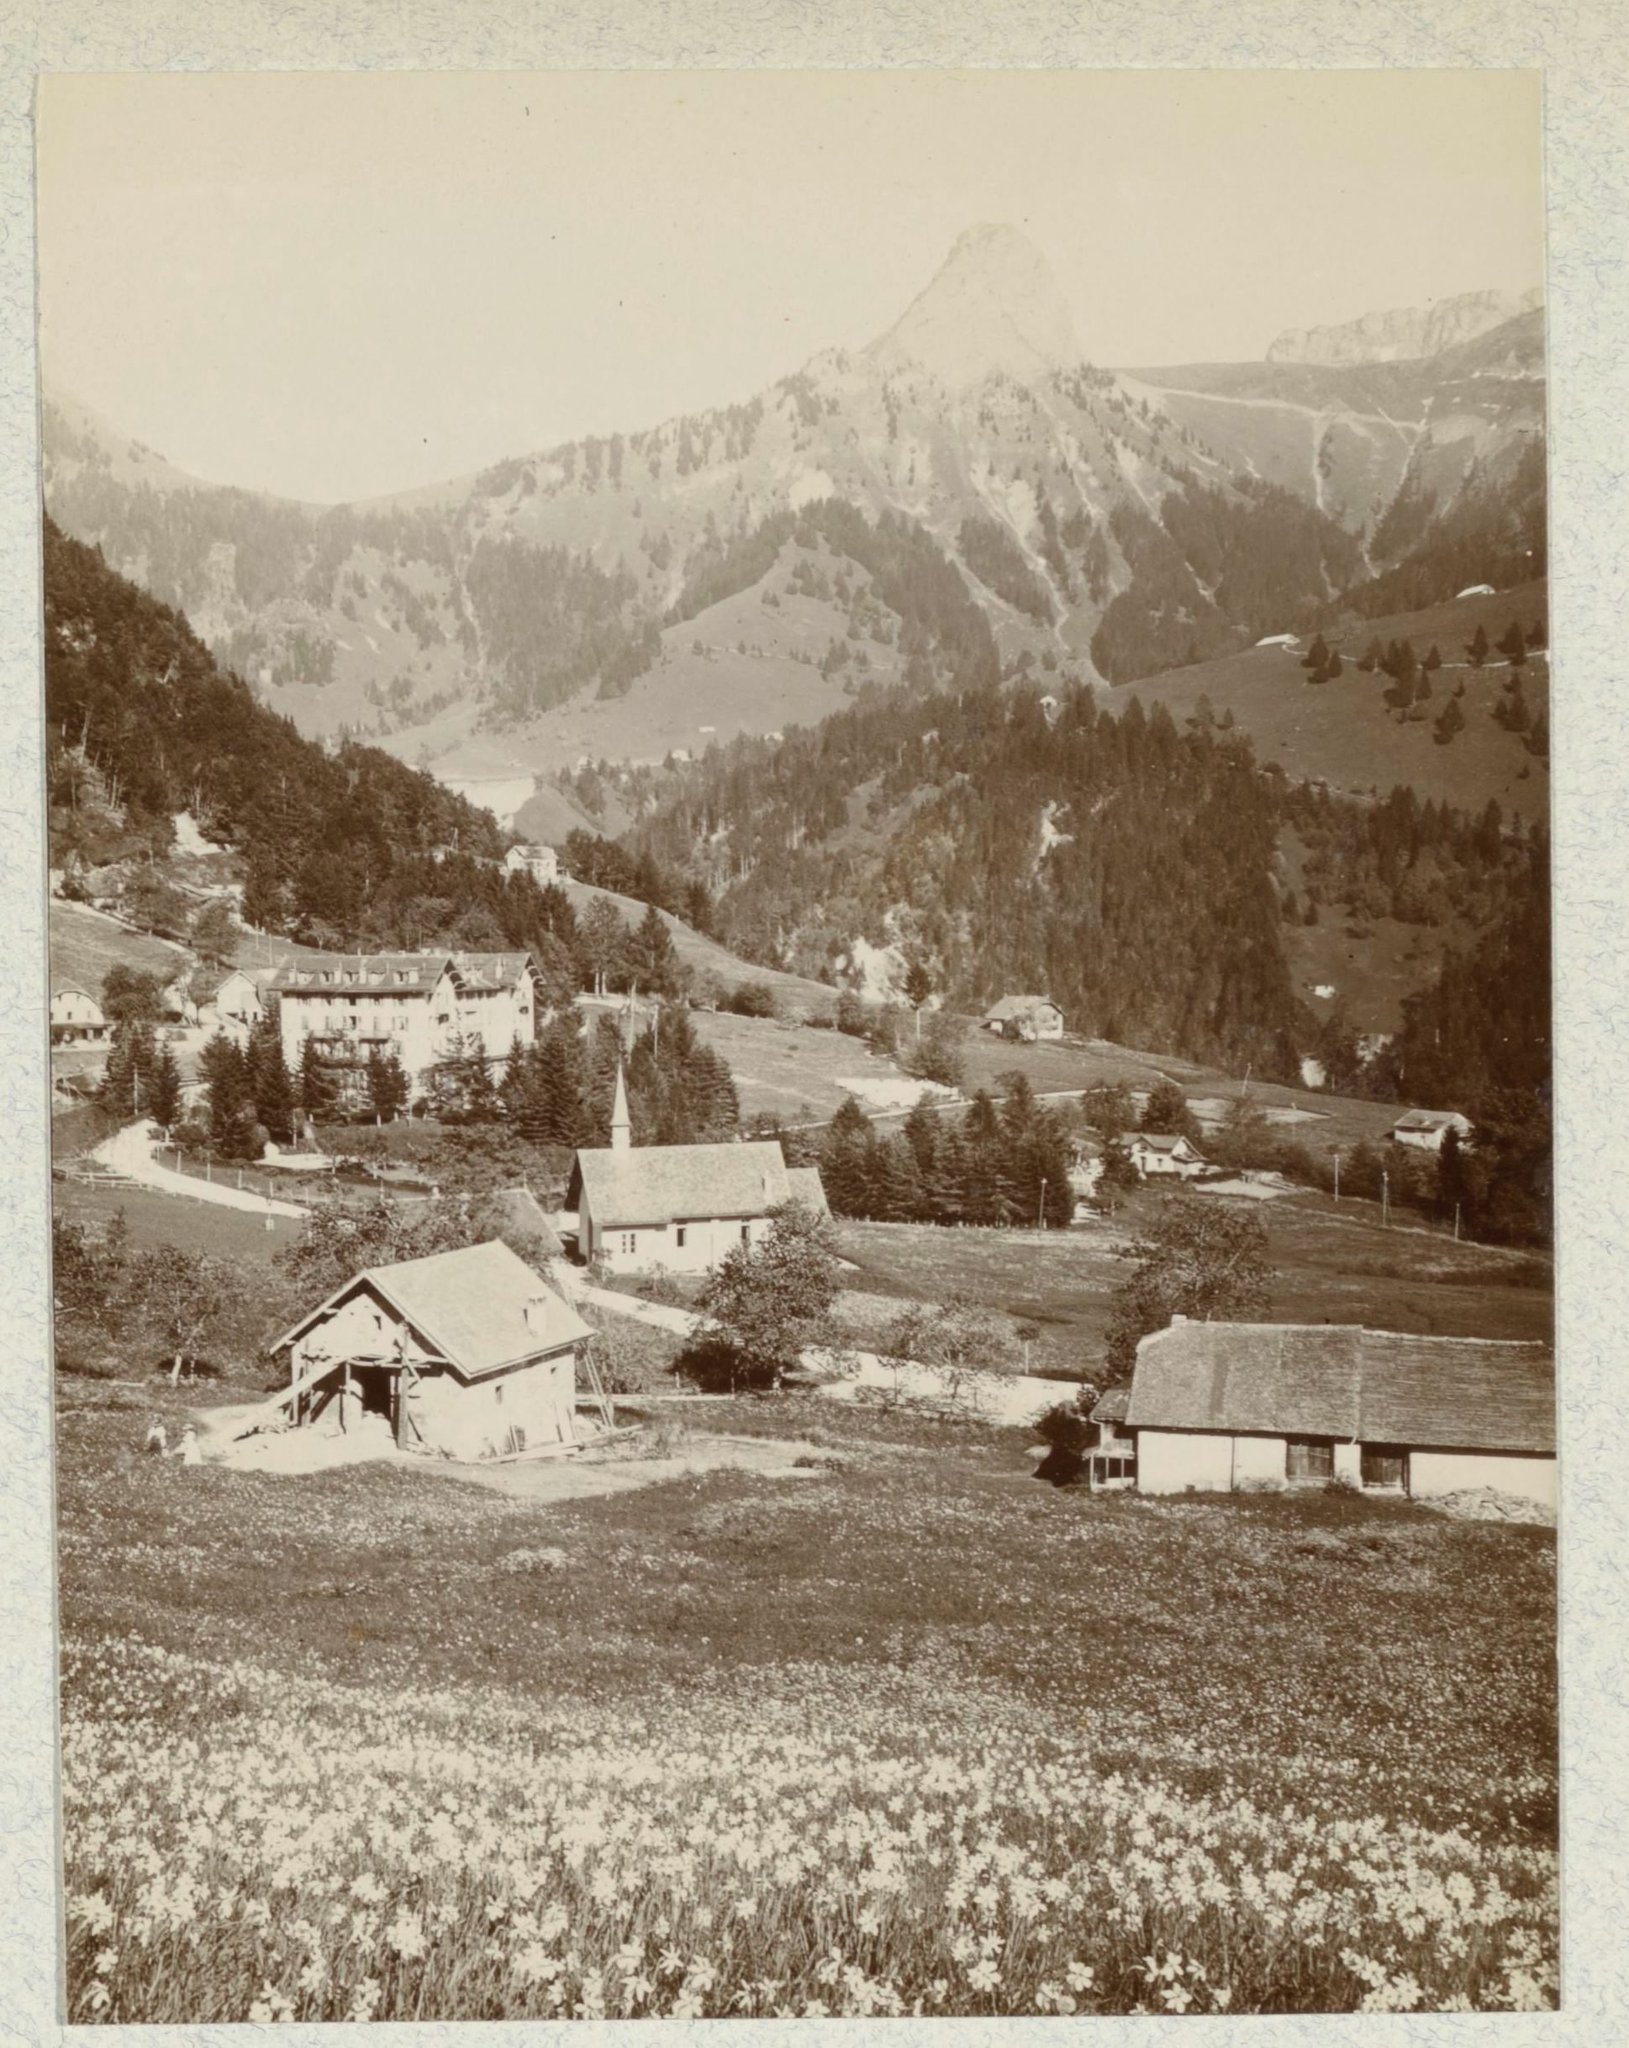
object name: photograph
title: Vakantie in Zwitserland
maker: andries augustus boom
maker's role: amateurfotograaf, handelaar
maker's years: 1878-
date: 1805-1899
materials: photographic support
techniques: photography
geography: switzerland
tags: amsterdam, andries augustus boom, switzerland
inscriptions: date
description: Vakantie in Zwitserland. Onderdeel van het fotoalbum van de familie Boom-Gonggrijp in Suriname en Curaçao.